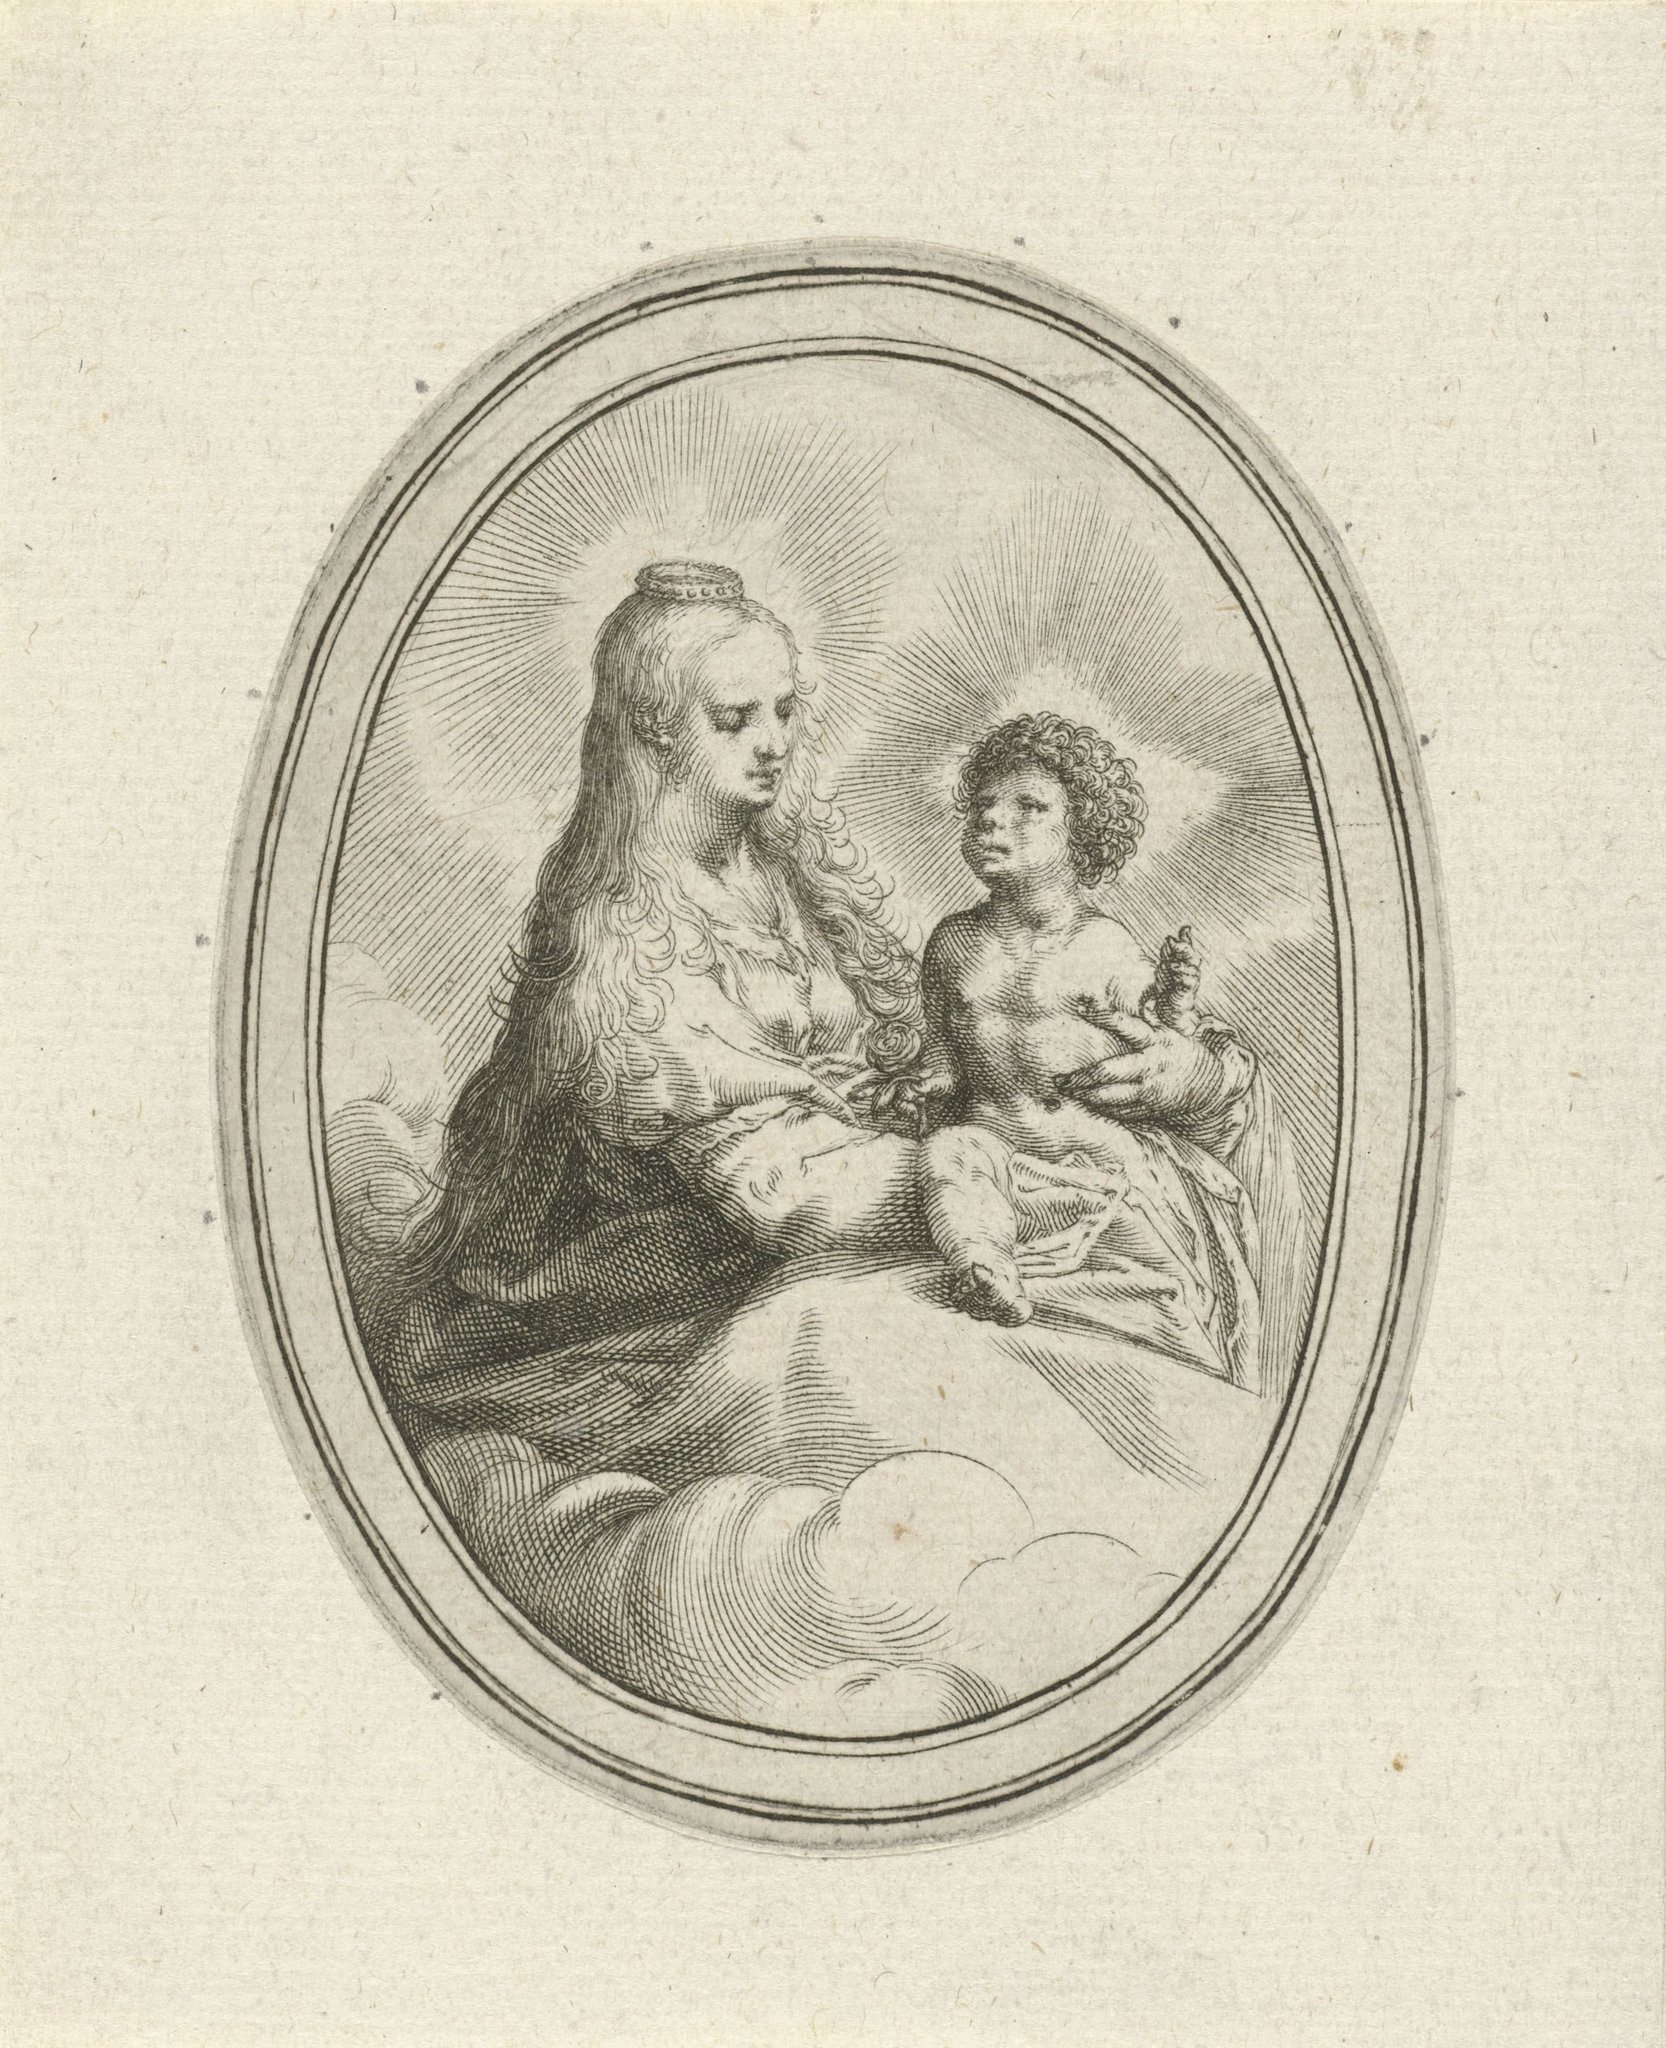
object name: print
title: Maria met kind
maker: harmen jansz muller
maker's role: print maker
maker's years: 1540-1617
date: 1593-1597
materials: paper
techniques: engraving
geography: amsterdam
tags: madonna: i.e. mary with the christ-child, flowers: rose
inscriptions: collector's mark: Lugt 240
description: Maria, gezeten op een wolk, met het Christuskind op haar schoot. Christus houdt een roos in de hand, Maria draagt een kroon.